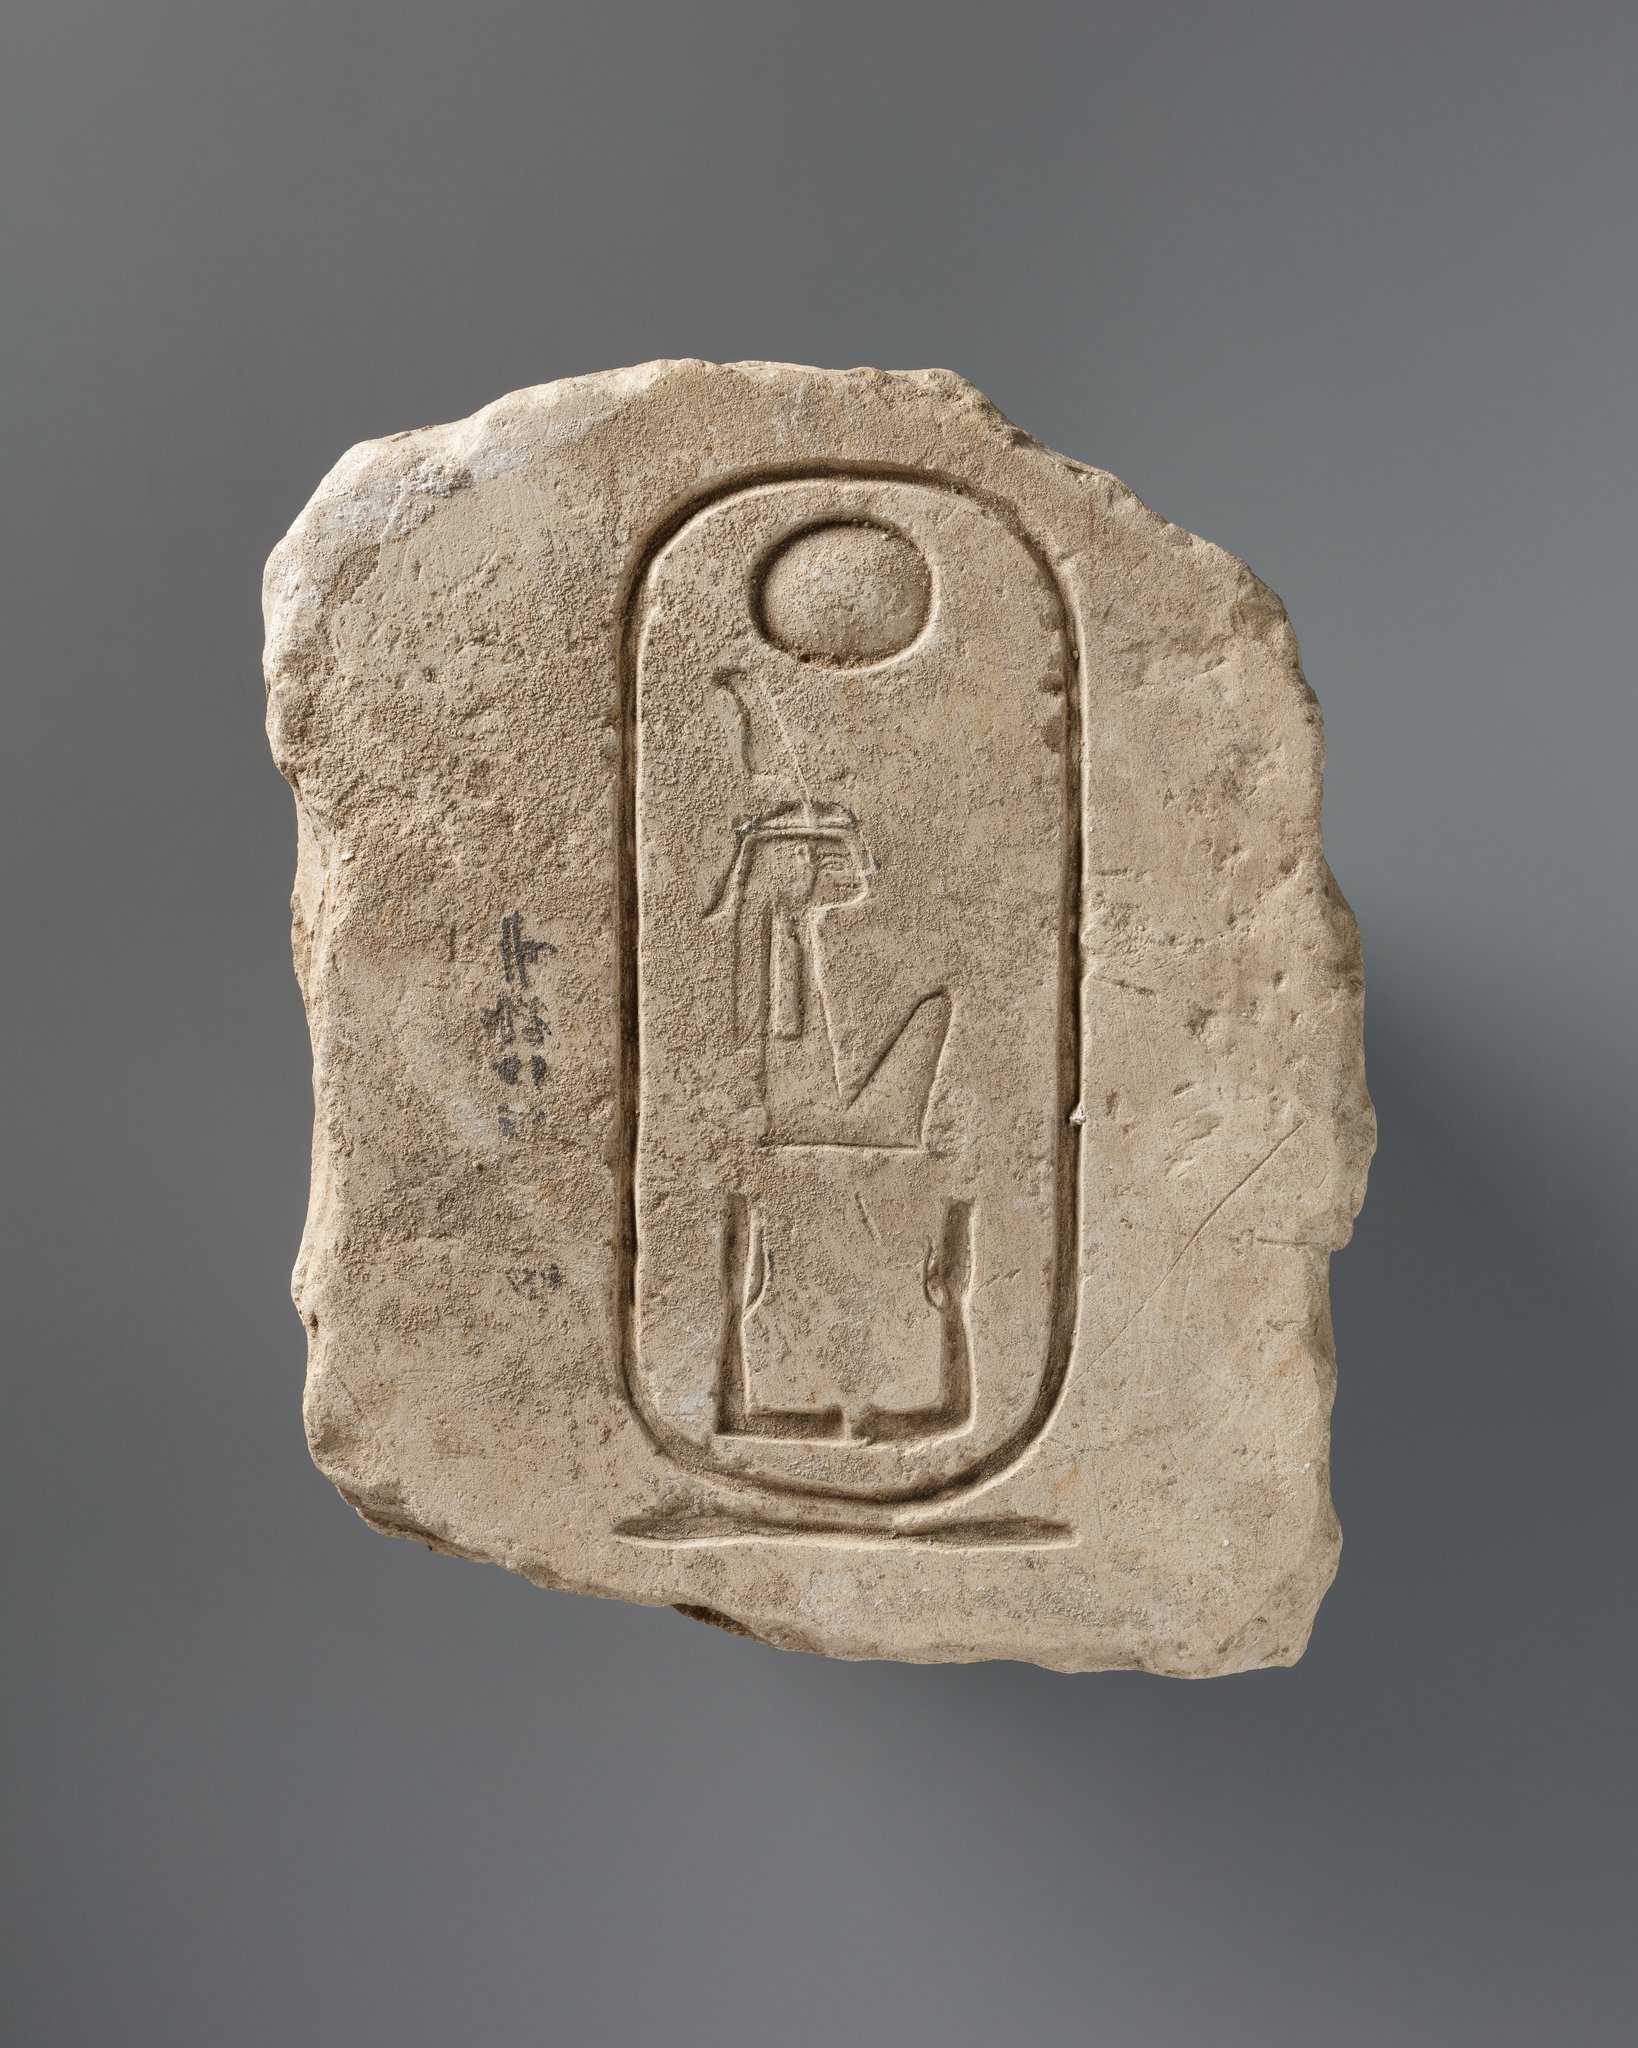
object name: inscribed stone, hatshepsut, maatkare, hieratic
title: Tally stone from Hatshepsut's Valley Temple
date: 1479-1458 BCE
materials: ink, limestone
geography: egypt